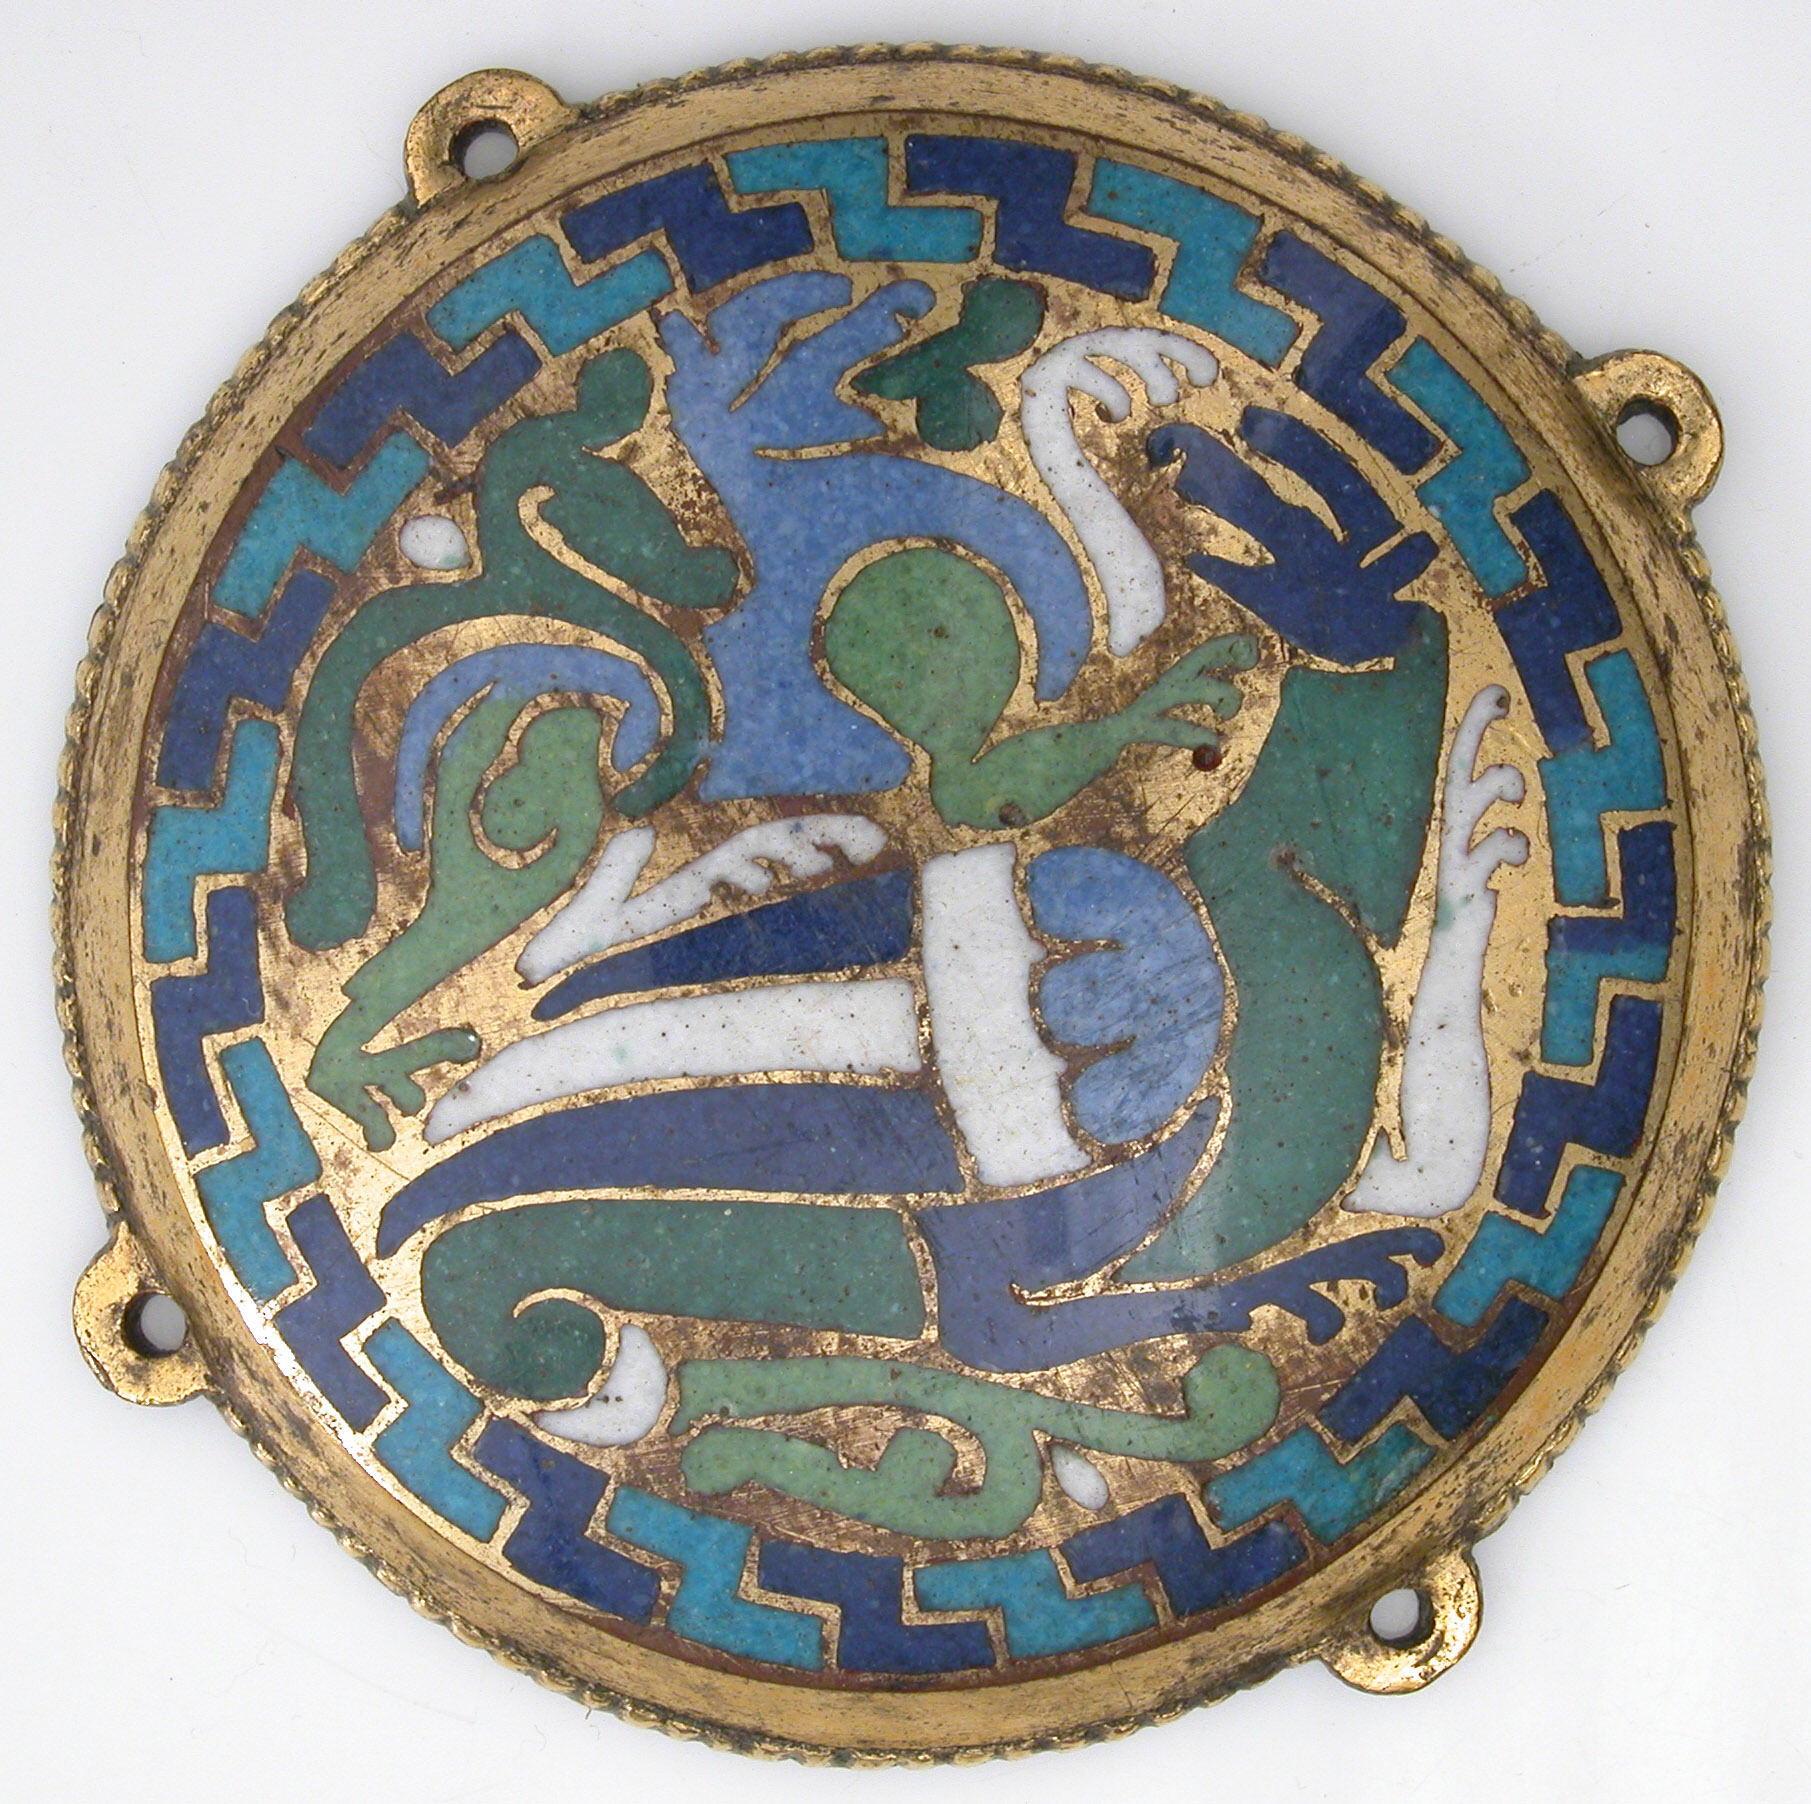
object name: medallion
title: Combat Between Dragon and Dog (one of five medallions from a coffret)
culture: french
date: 1110-1130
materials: gilt copper, enamel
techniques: enamel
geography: france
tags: dragons,dogs